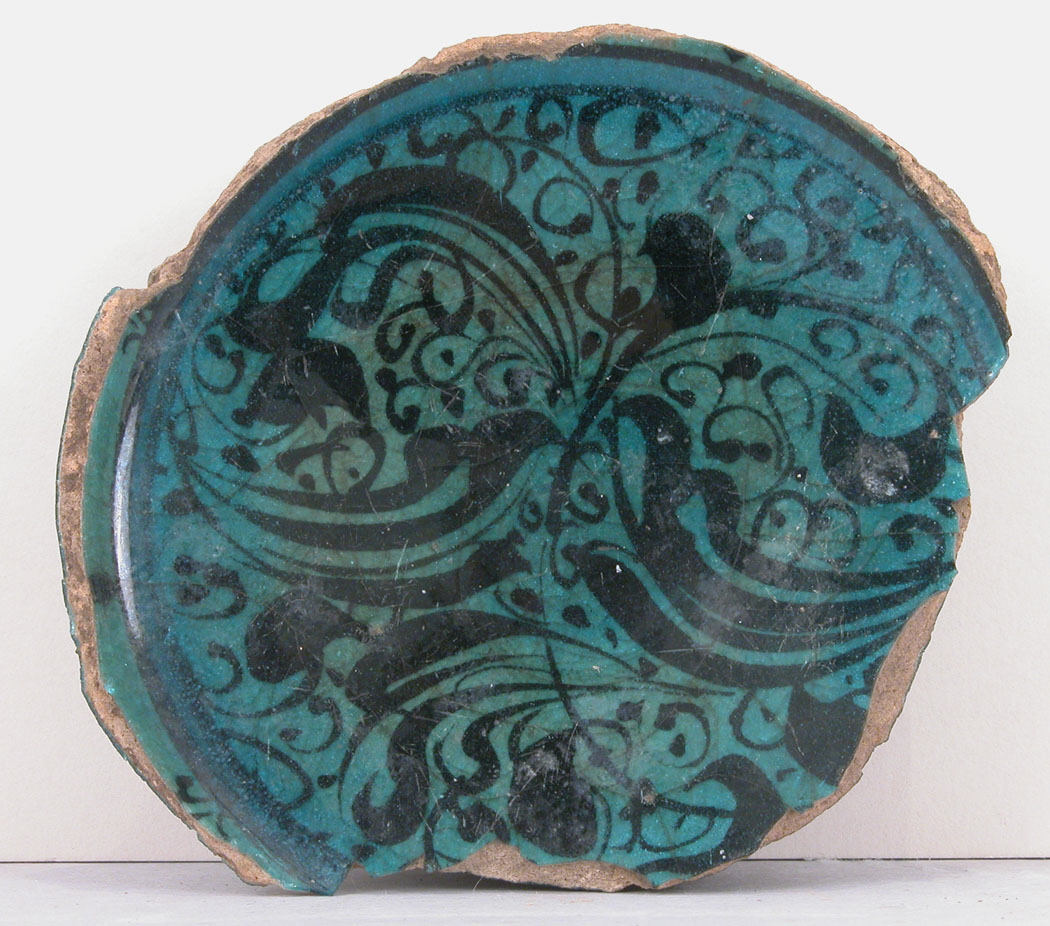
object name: ceramic fragment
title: Fragment of a Bowl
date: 1201-1400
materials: stonepaste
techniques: painting, underglaze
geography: syria